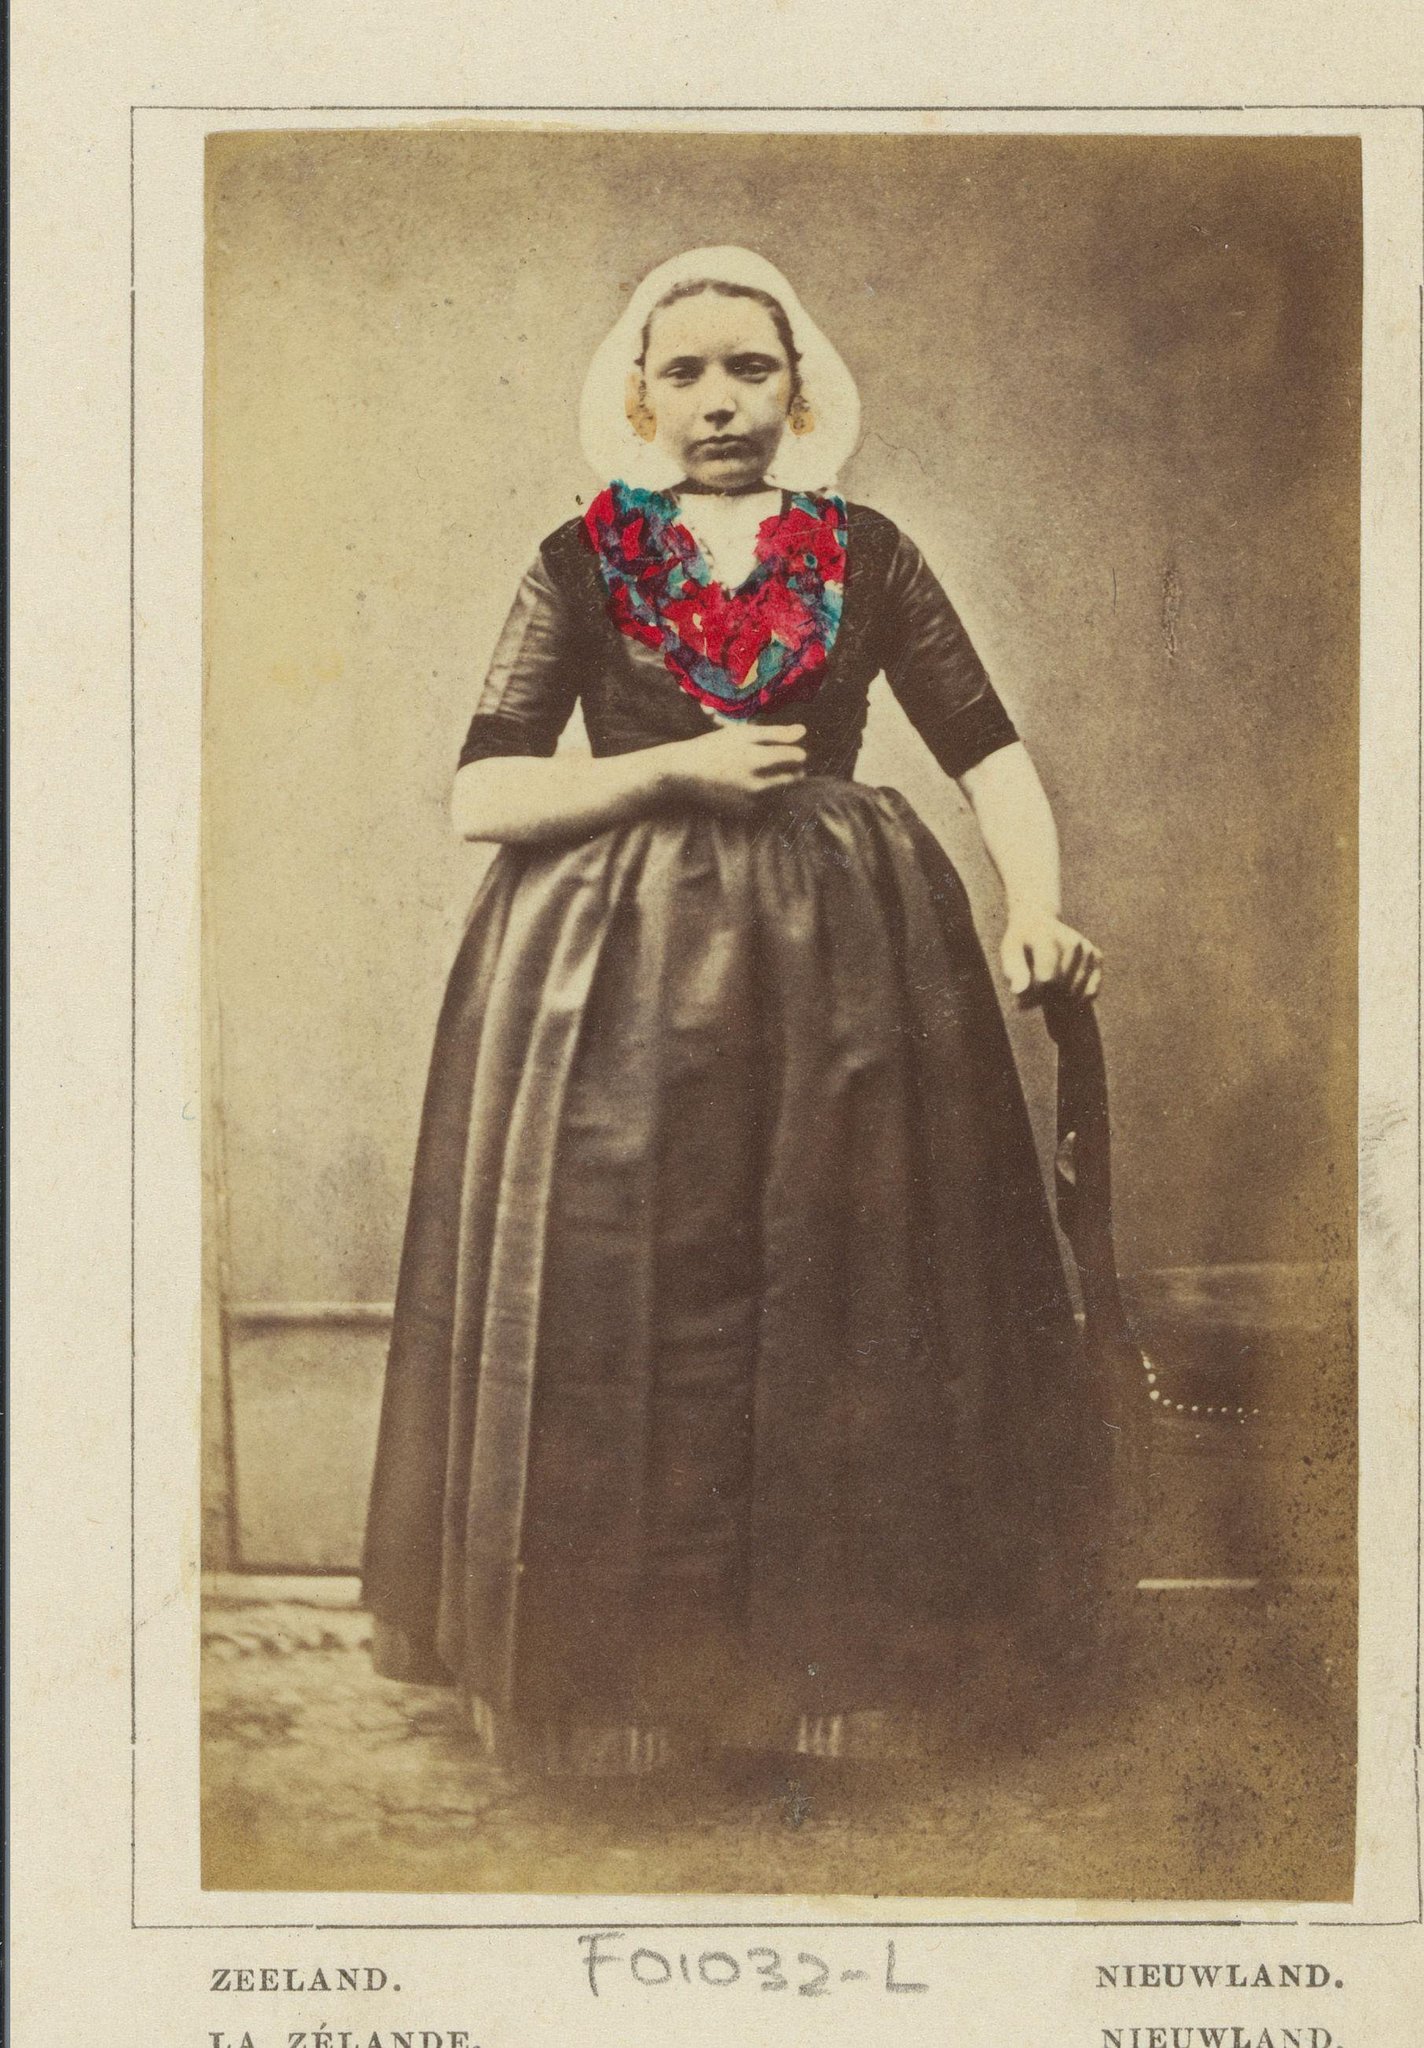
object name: photograph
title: Nederlandsche Kleederdragten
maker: andries jager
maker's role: publisher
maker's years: 1825-1905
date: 1860-1890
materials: cardboard, photographic support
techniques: albumen print, hand coloring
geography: amsterdam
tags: folk costume, regional costume (+ women's clothes), historical persons - bb - woman, europeans (with name), netherlands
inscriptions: inscription: ‘Uitgave van A. JAGER, Water 110 te Amsterdam.’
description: Deze foto maakt deel uit van een omslag met 48 foto's op 12 bladen.